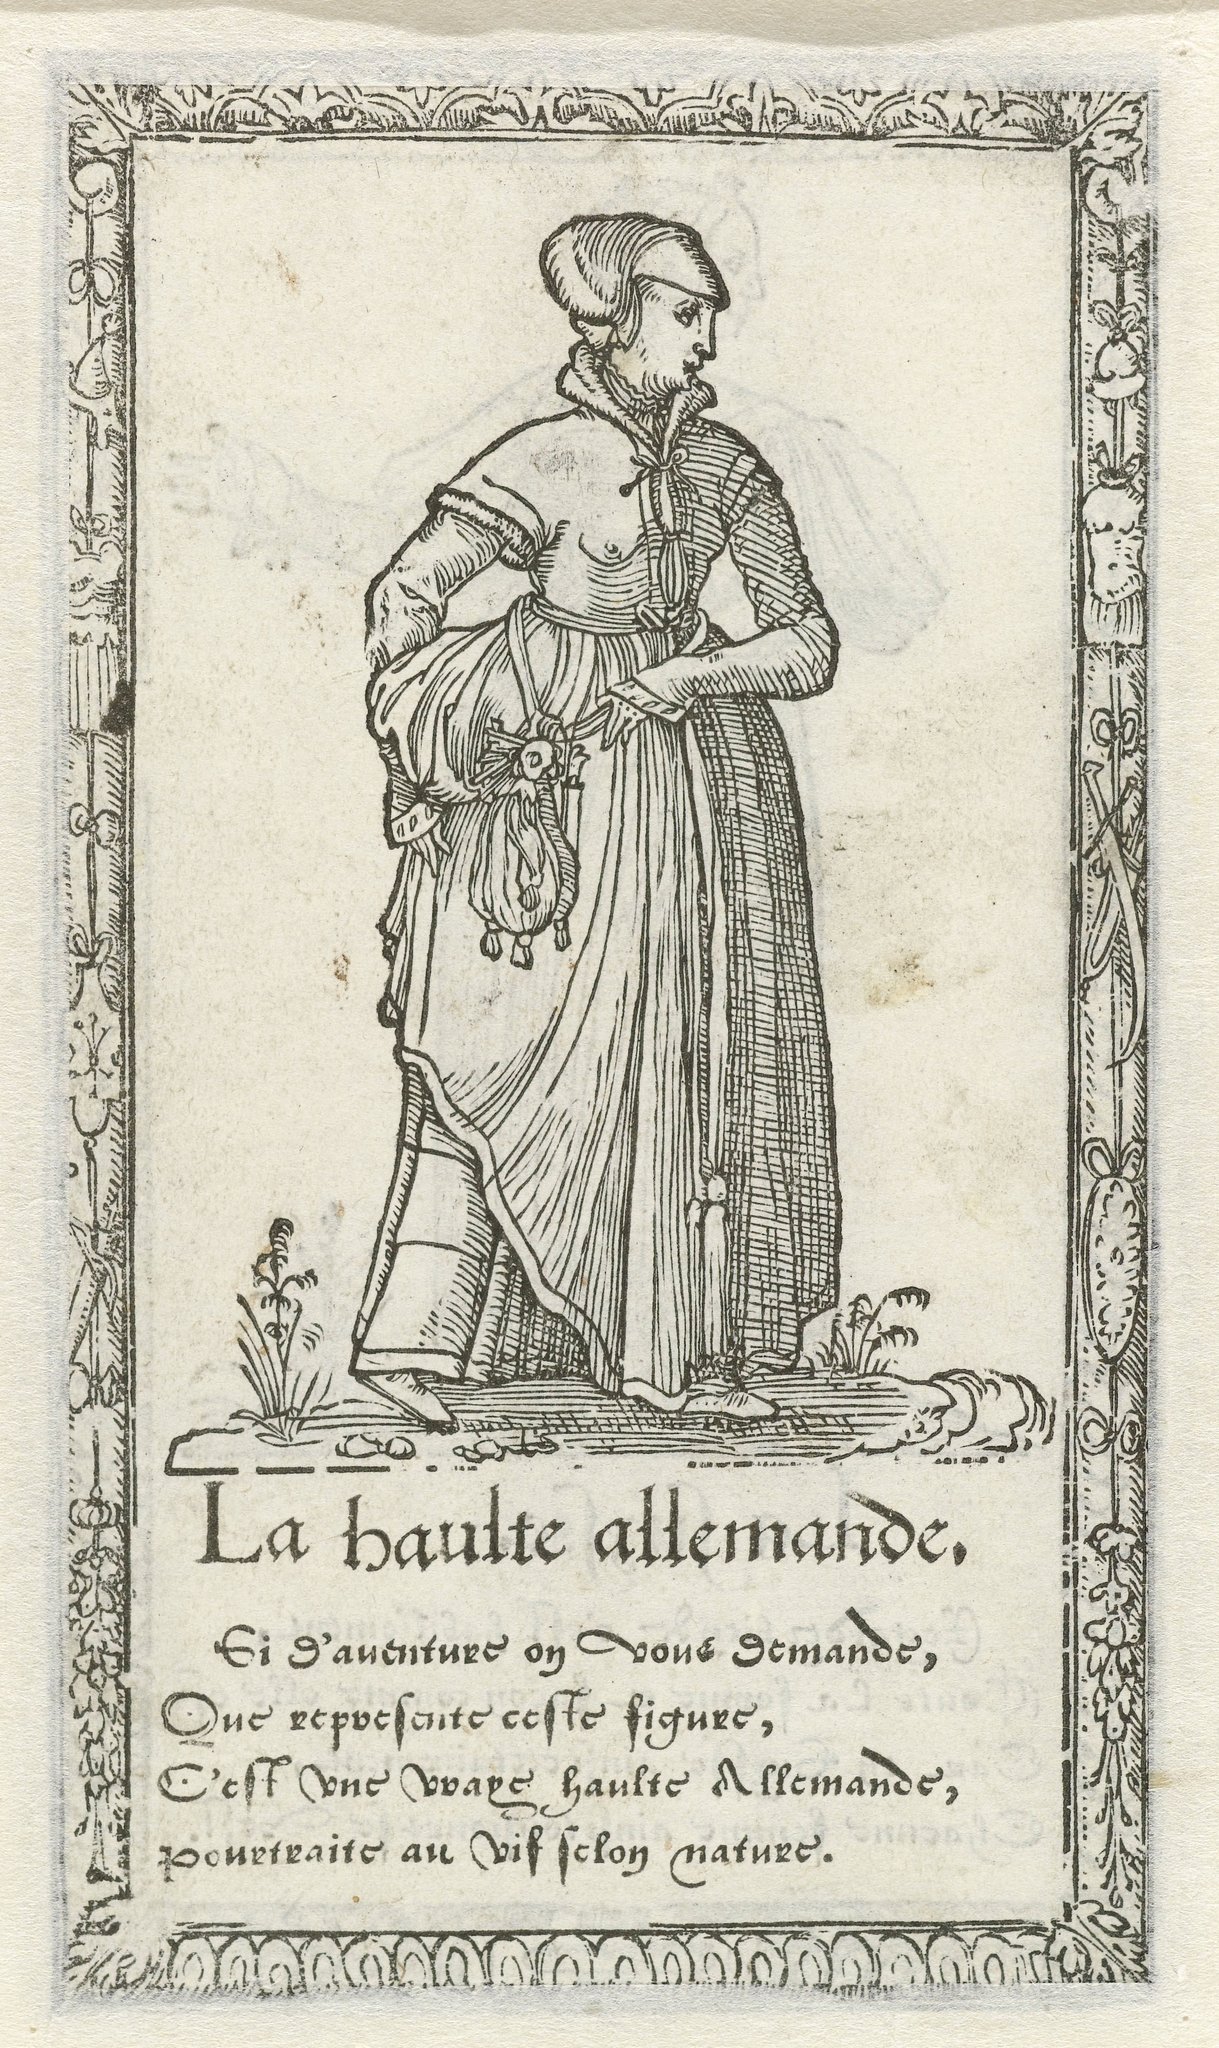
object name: print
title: Serie van verschillende klederdrachten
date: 1562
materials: paper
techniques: woodcut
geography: paris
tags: fashion plates, europeans: germans (+ costume), folk costume, regional costume, dress, gown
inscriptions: collector's mark: Lugt 2228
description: Dit is prent 62 uit een serie van 121. Binnen deze serie zijn er prenten gemaakt naar voorbeelden van Jean-François de Roberval en Enea Vico, onbekend welke precies.